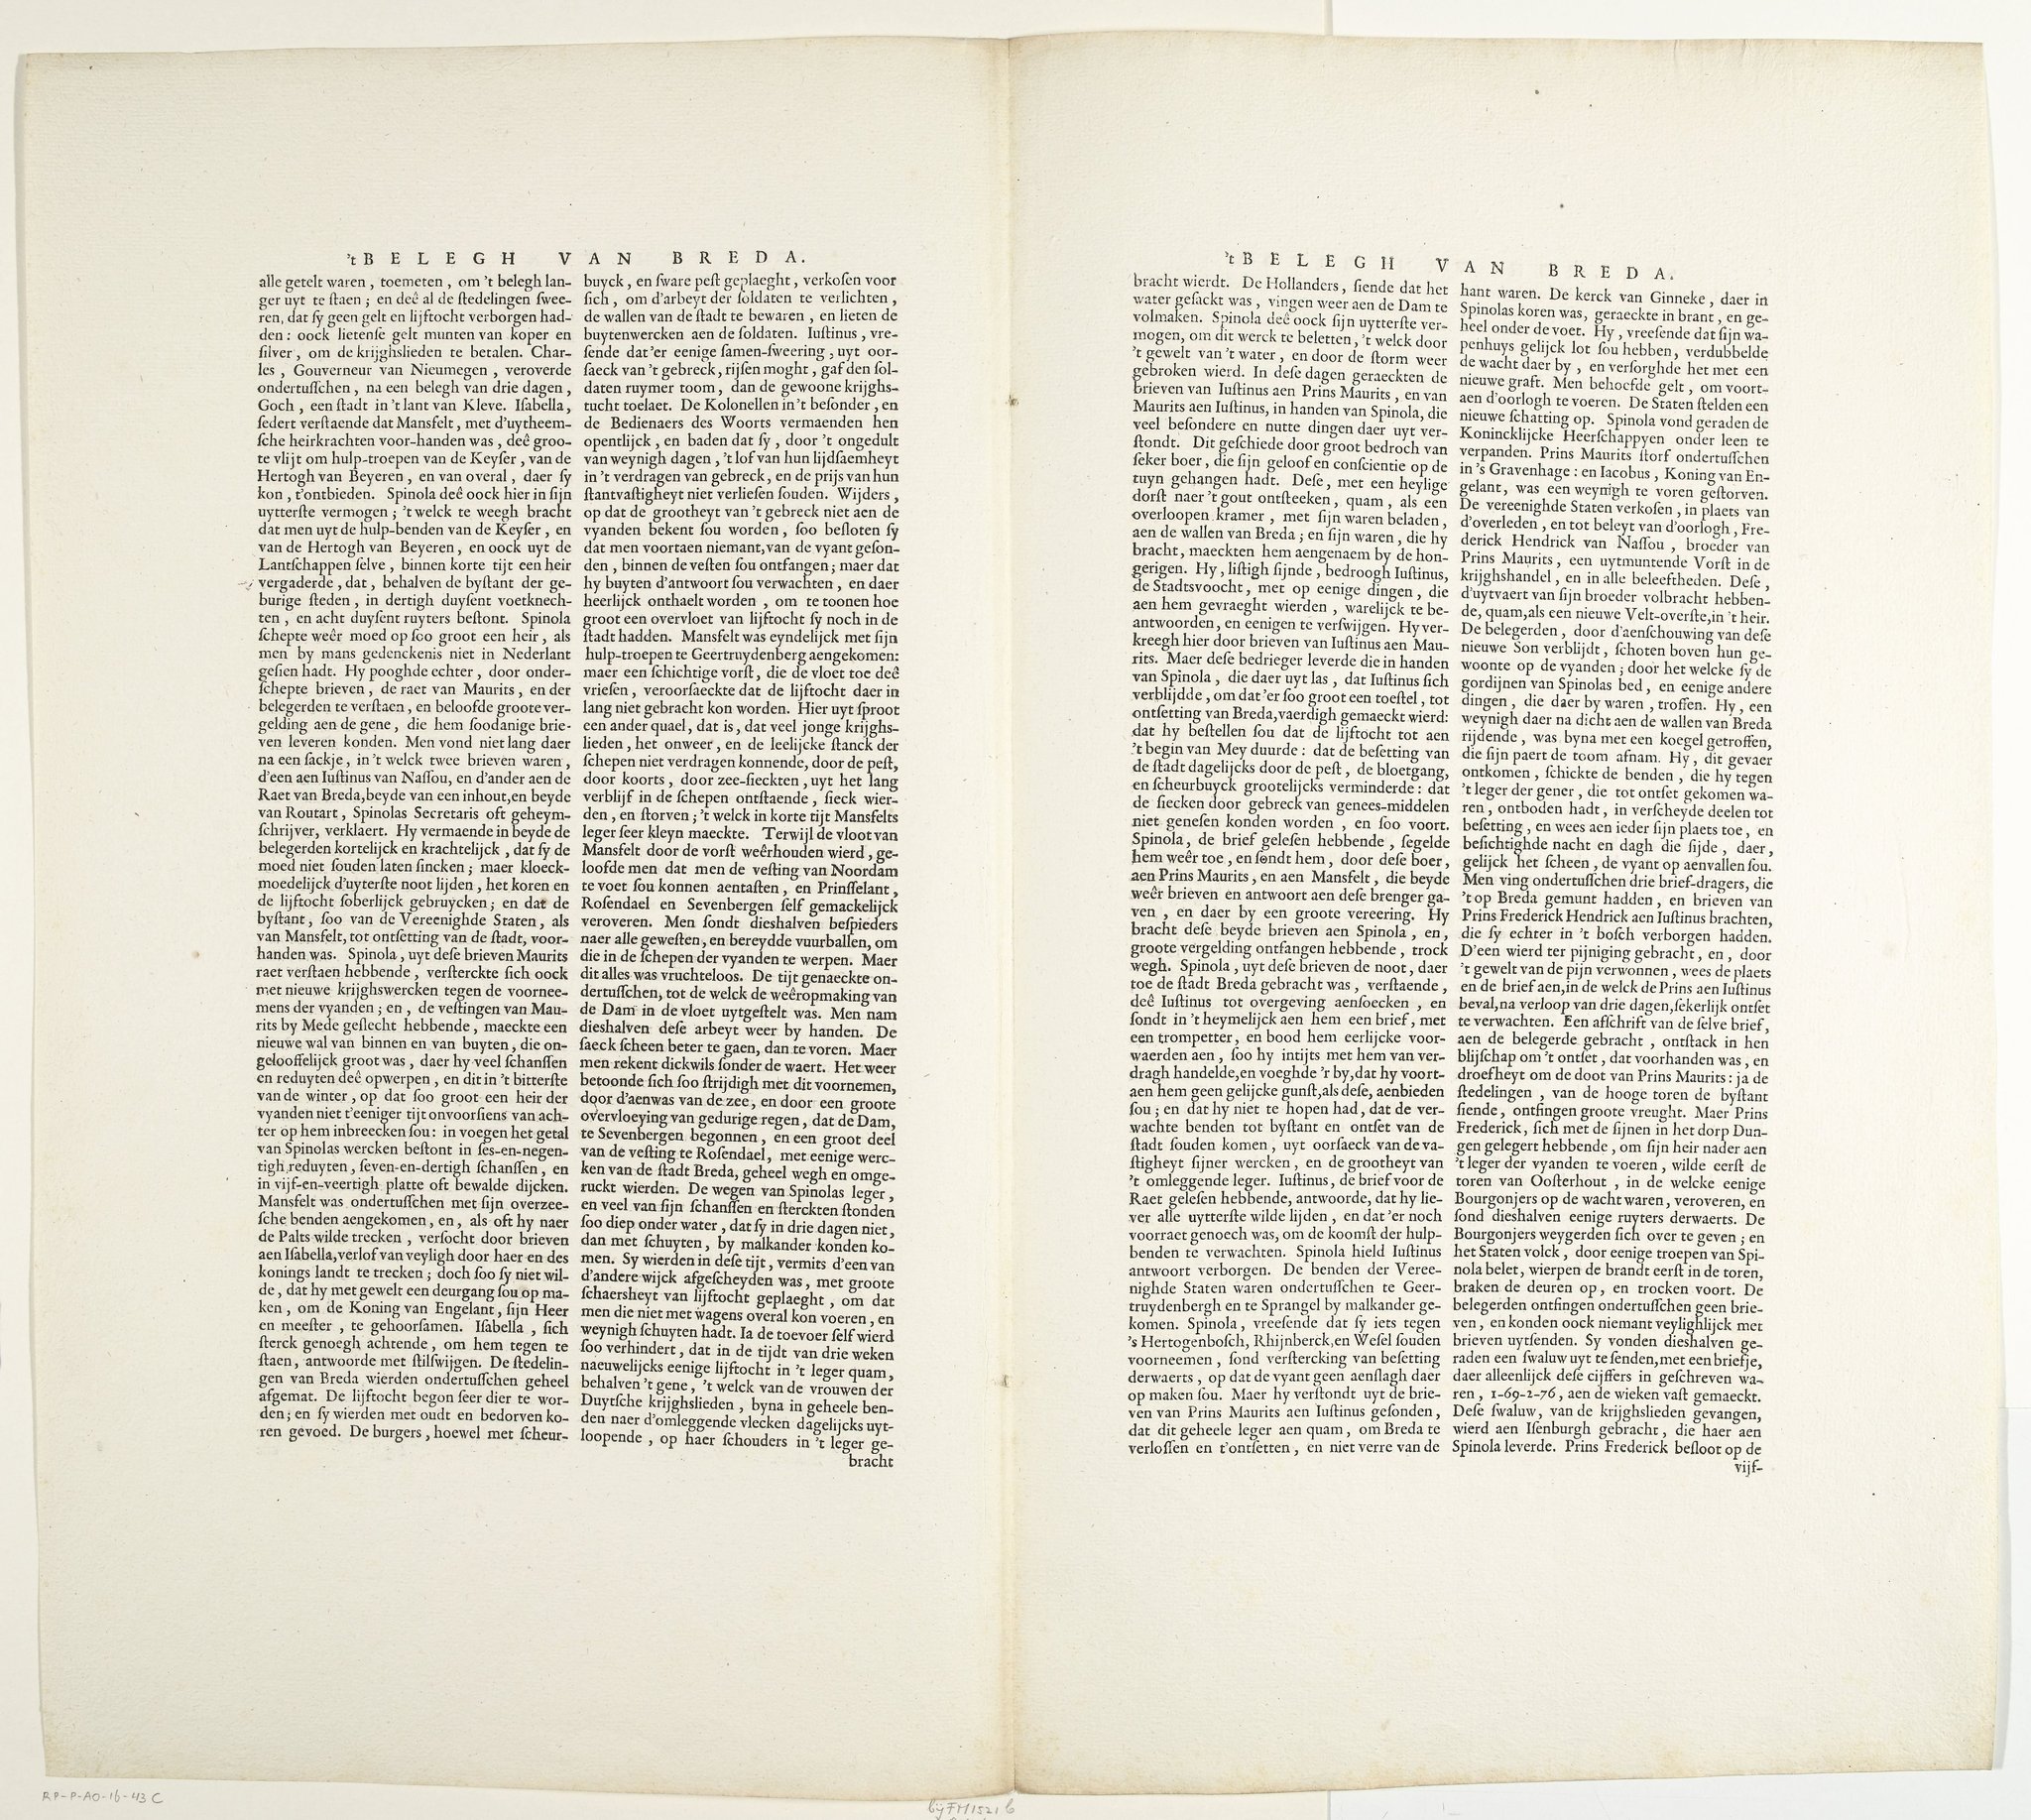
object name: text sheet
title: Tweede tekstblad bij de kaart van het beleg van Breda, 1624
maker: johannes willemszoon blaeu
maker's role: printer, publisher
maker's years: 1596-1673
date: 1649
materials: paper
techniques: letterpress printing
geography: amsterdam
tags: genua, castelnuovo scrivia, veldheer, ambrogio spinola (markies de los balbases), beleg van breda (1624-1625)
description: Tweede tekstblad bij de kaart van het beleg van Breda door het Spaanse leger onder Spinola, 27 augustus 1624 tot 5 juni 1625. Dubbelblad genomen uit het Stedenboek van Blaeu, bedrukt op beide zijden met tekst in het Nederlands.